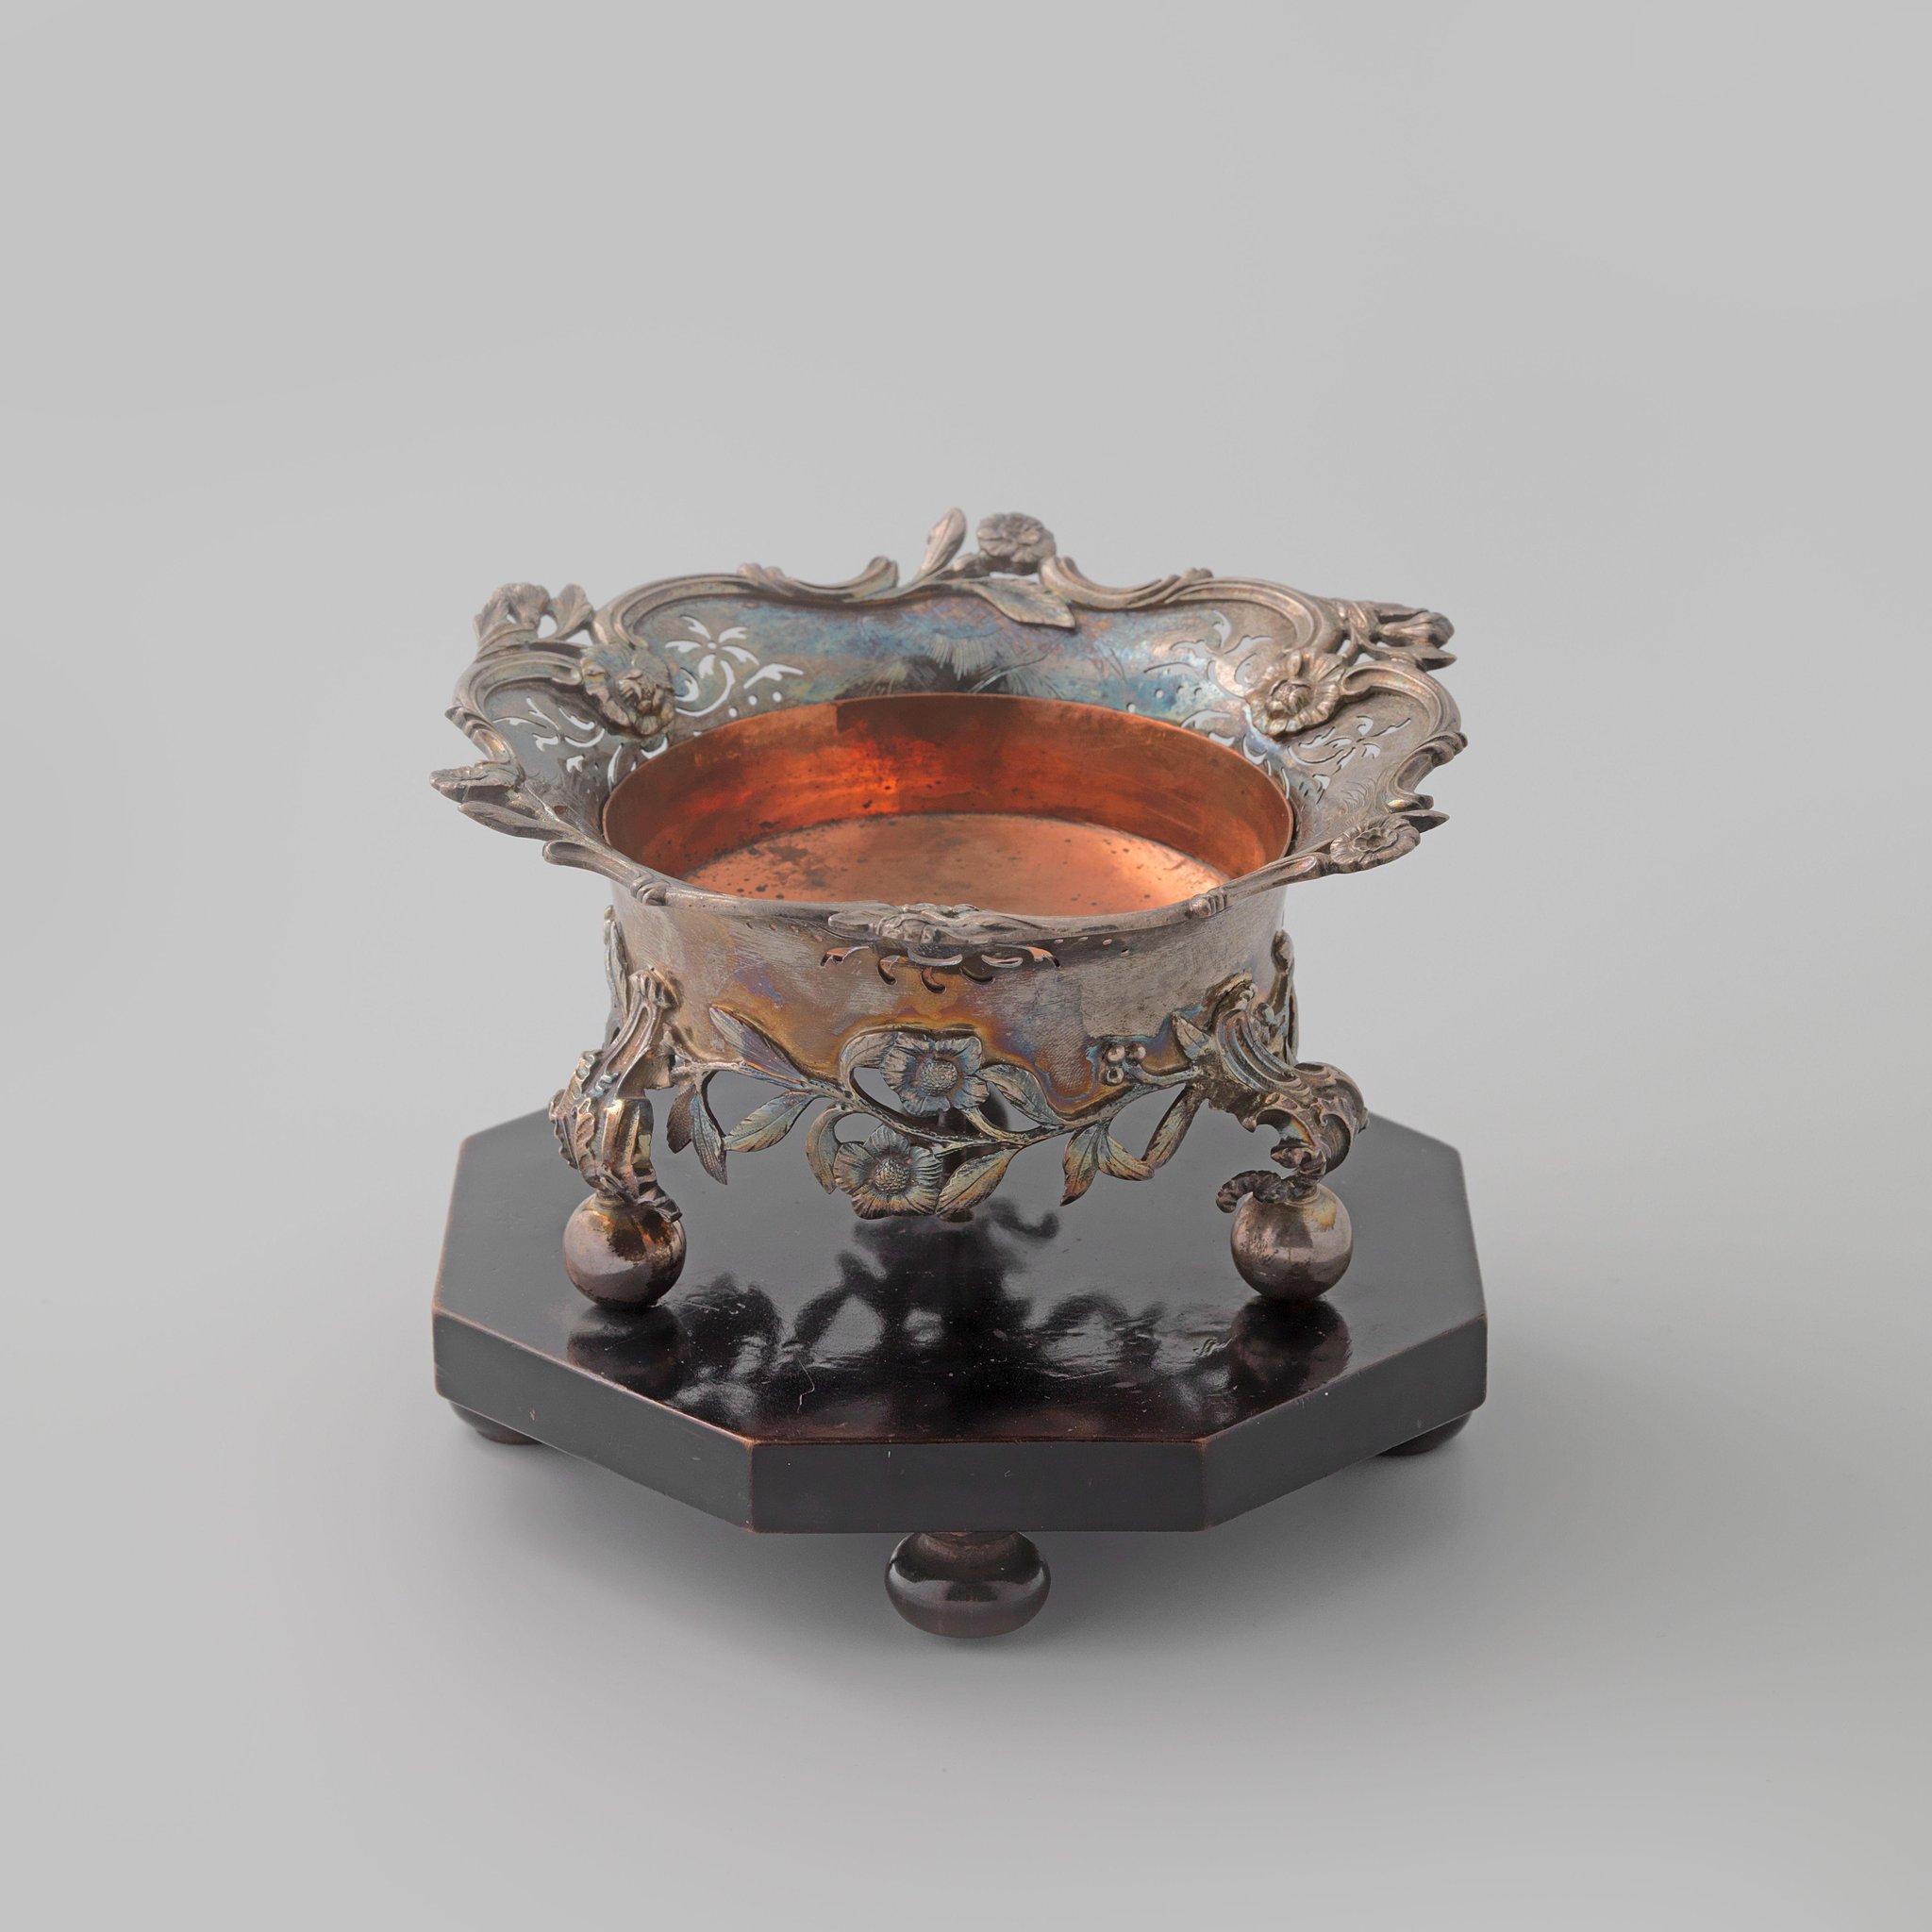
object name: komfoor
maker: Anonymous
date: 1768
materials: copper, silver, wood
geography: amsterdam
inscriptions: mark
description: Komfoor van zilver op drie pootjes, met een koperen binnenbak en op een houten blad. De diepe ovale bak heeft een horizontaal uitgebogen rand. Opzij 2 ringdragende leeuwenkopjes.